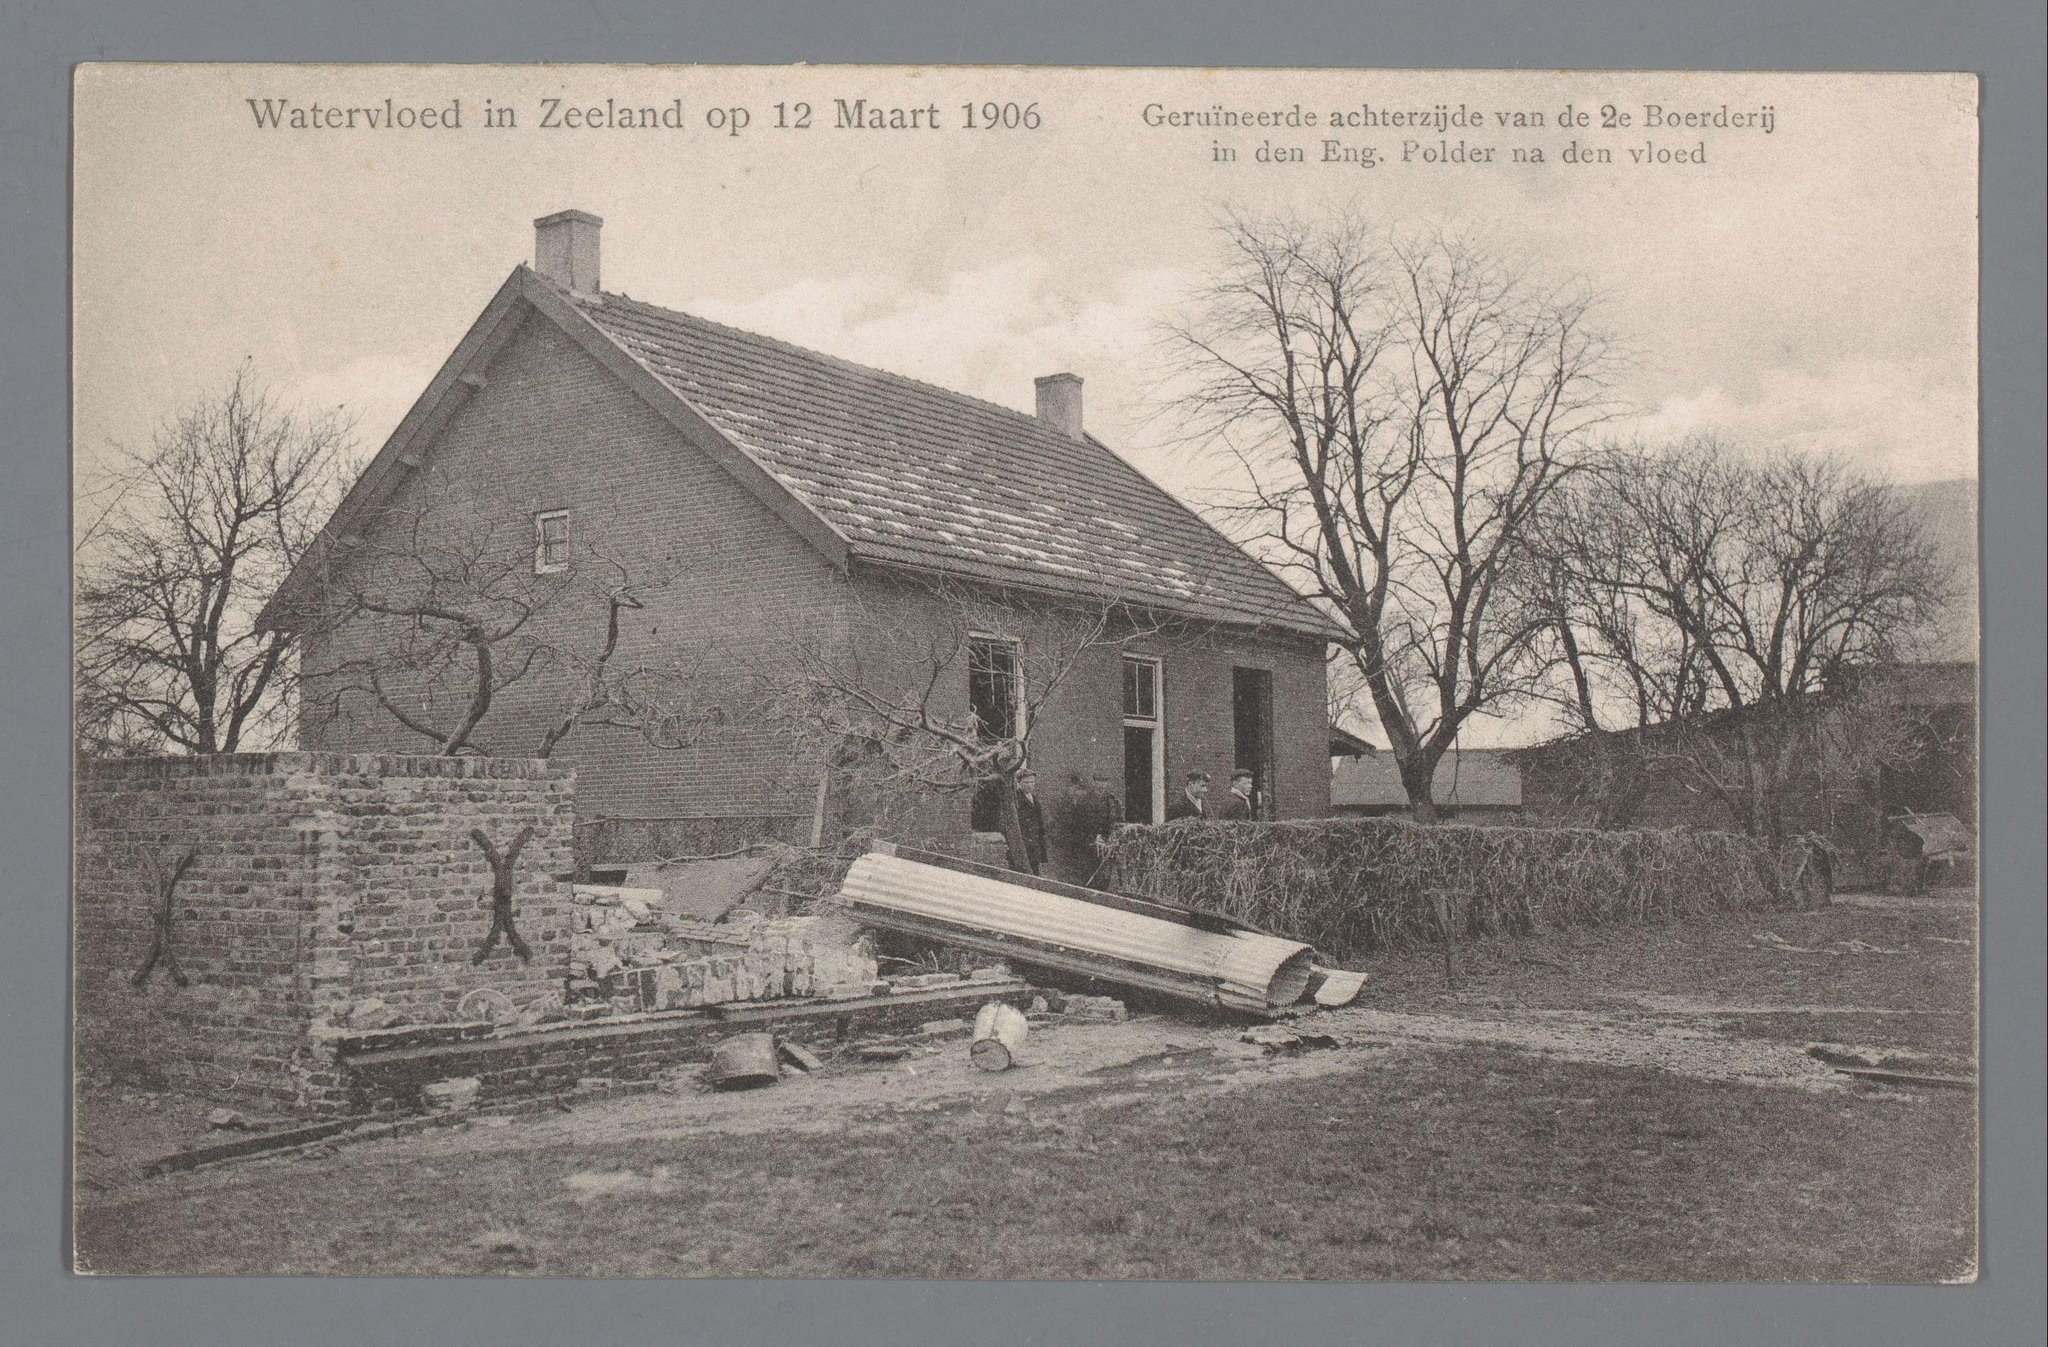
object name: ansichtkaart, prentbriefkaart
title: Watervloed in Zeeland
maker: p.j. daniëlse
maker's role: publisher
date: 1906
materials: paper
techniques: printing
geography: middelburg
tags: zeeland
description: Briefkaart, zwart-wit. Watersnood 12 maart 1906.